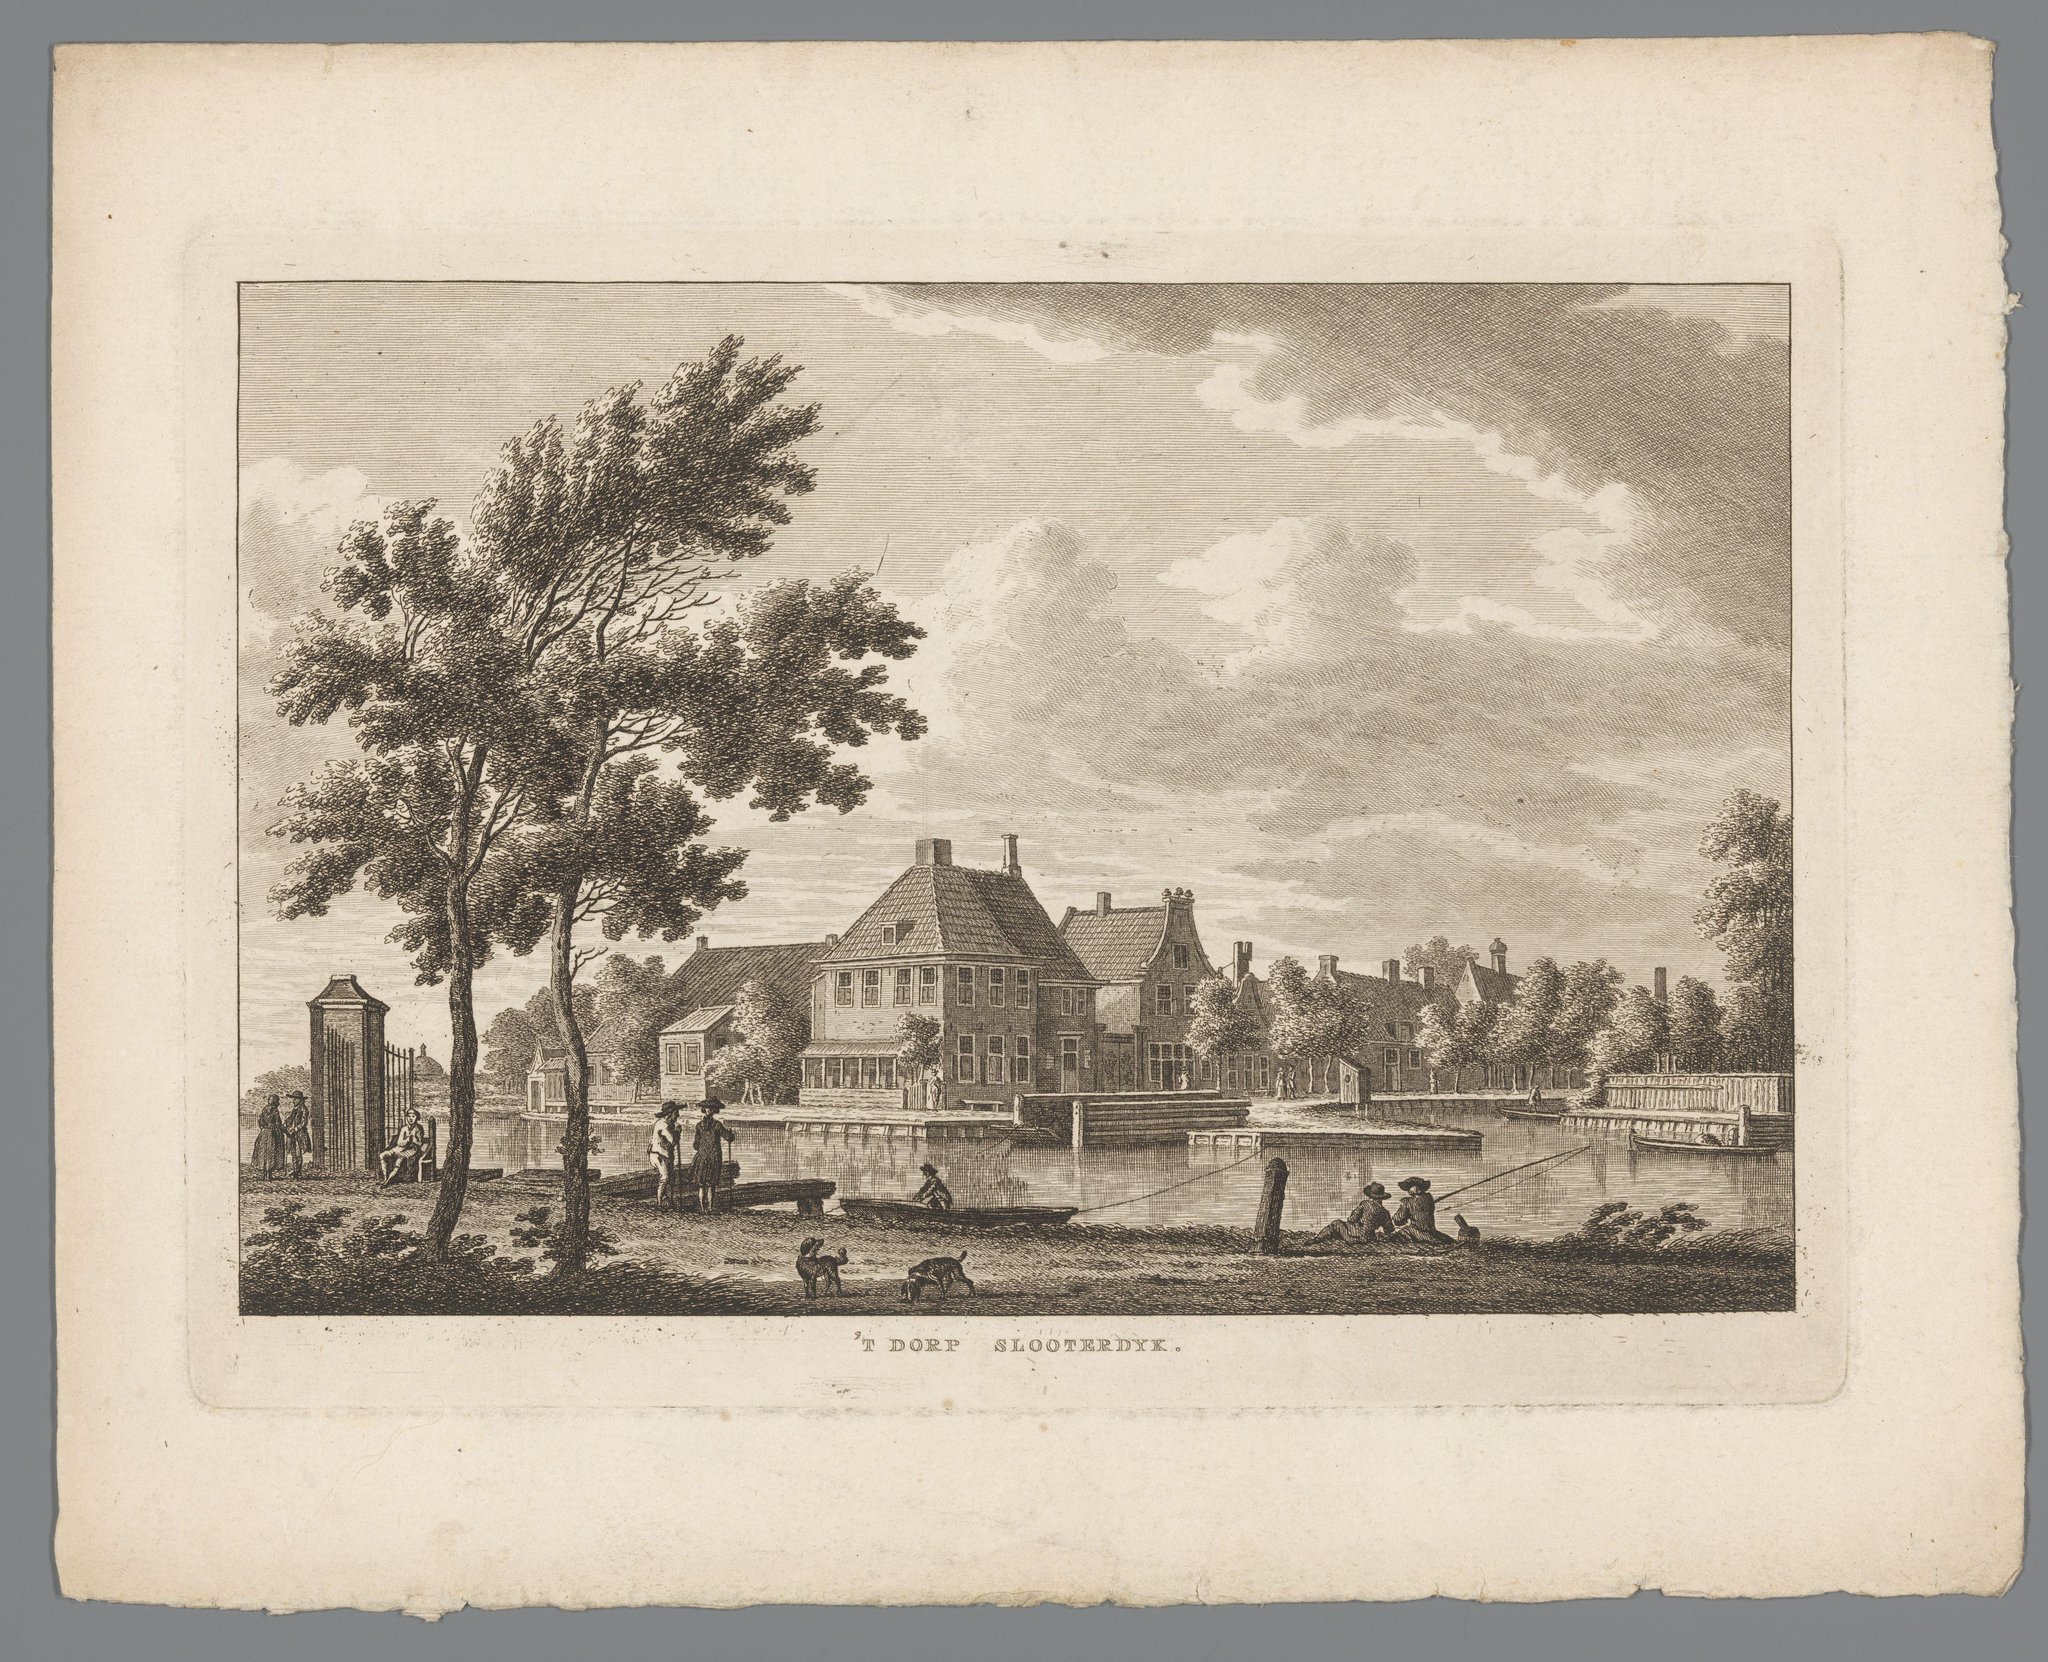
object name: print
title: 't Dorp Slooterdyk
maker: carel frederik bendorp (i)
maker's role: print maker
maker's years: 1736-1814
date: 1786-1792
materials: paper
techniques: etching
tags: village, sloterdijk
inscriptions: collector's mark: Lugt 2233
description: Prent uit: Vaderlandsche gezichten, of afbeeldingen van den tegenwoordigen staat der Vereenigde Nederlanden (…). Amsterdam: Hendrik Gartman, Willem Vermandel en Jan Willem Smit, 1786-1792. Uitgegeven in afleveringen met ieder een eigen bifolium en inhoudsopgave. Alle prenten in deze publicatie zijn gegraveerd door Carel Frederik Bendorp (I) en, in de meeste gevallen, gebaseerd op tekeningen van Jan Bulthuis.